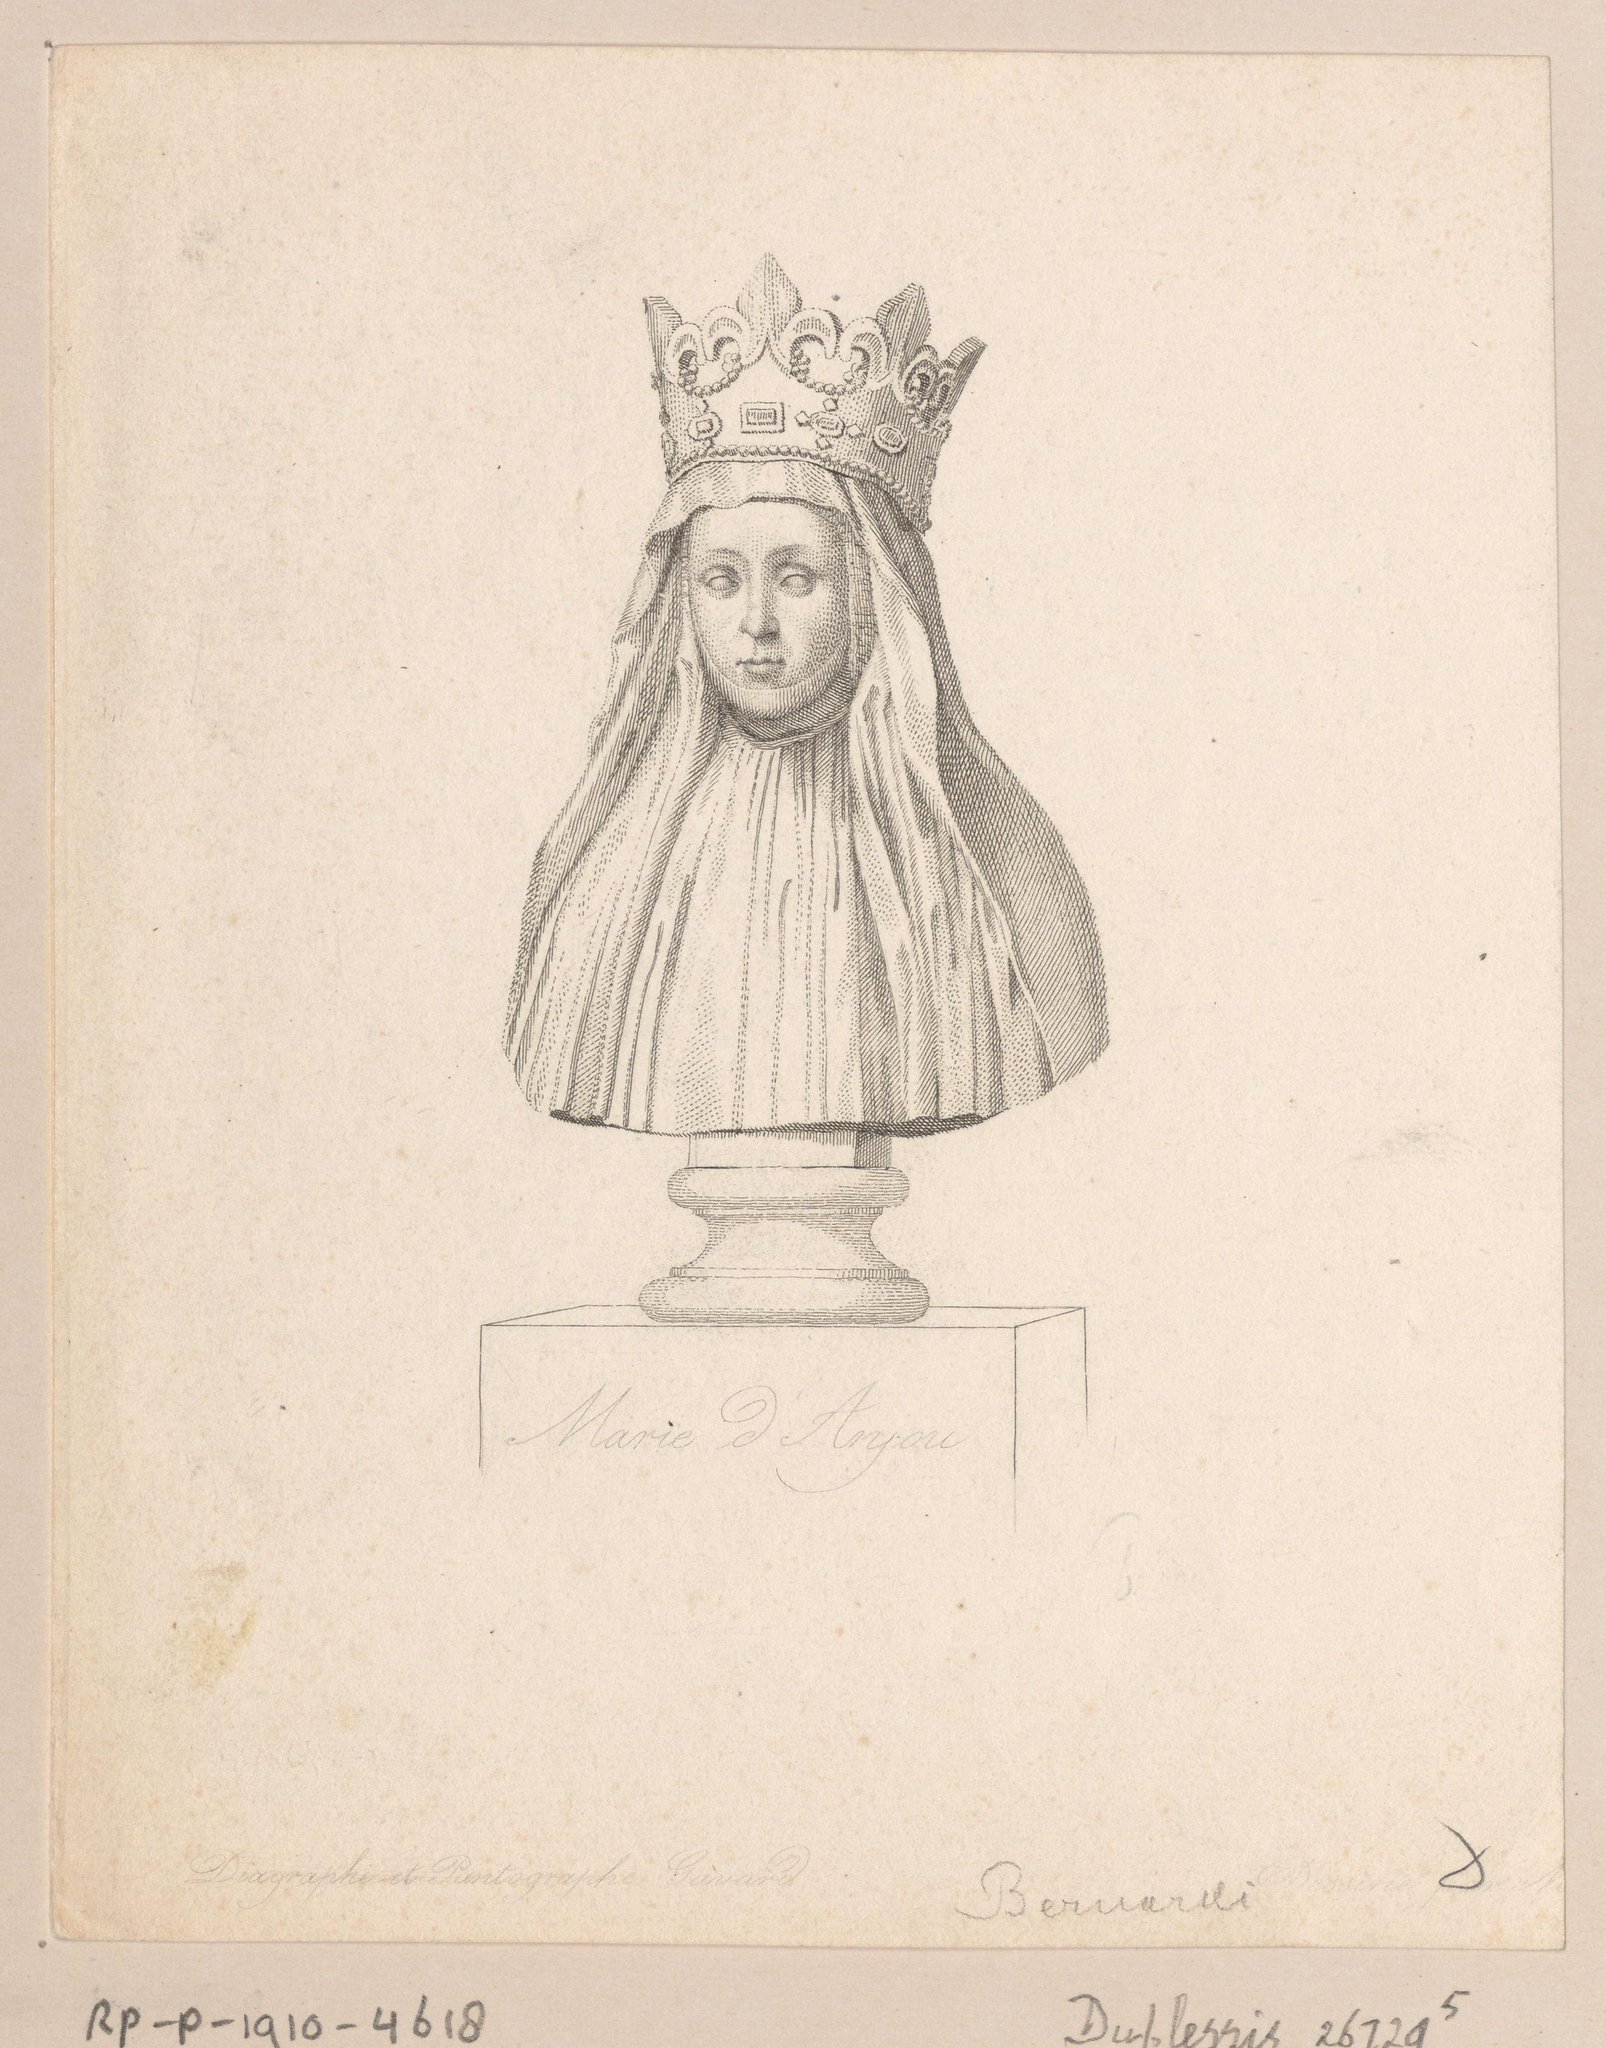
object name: print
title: Historische galerij van Versailles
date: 1837-1848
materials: paper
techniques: etching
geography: france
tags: historical persons - bb - woman, queen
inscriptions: collector's mark: Lugt 2228